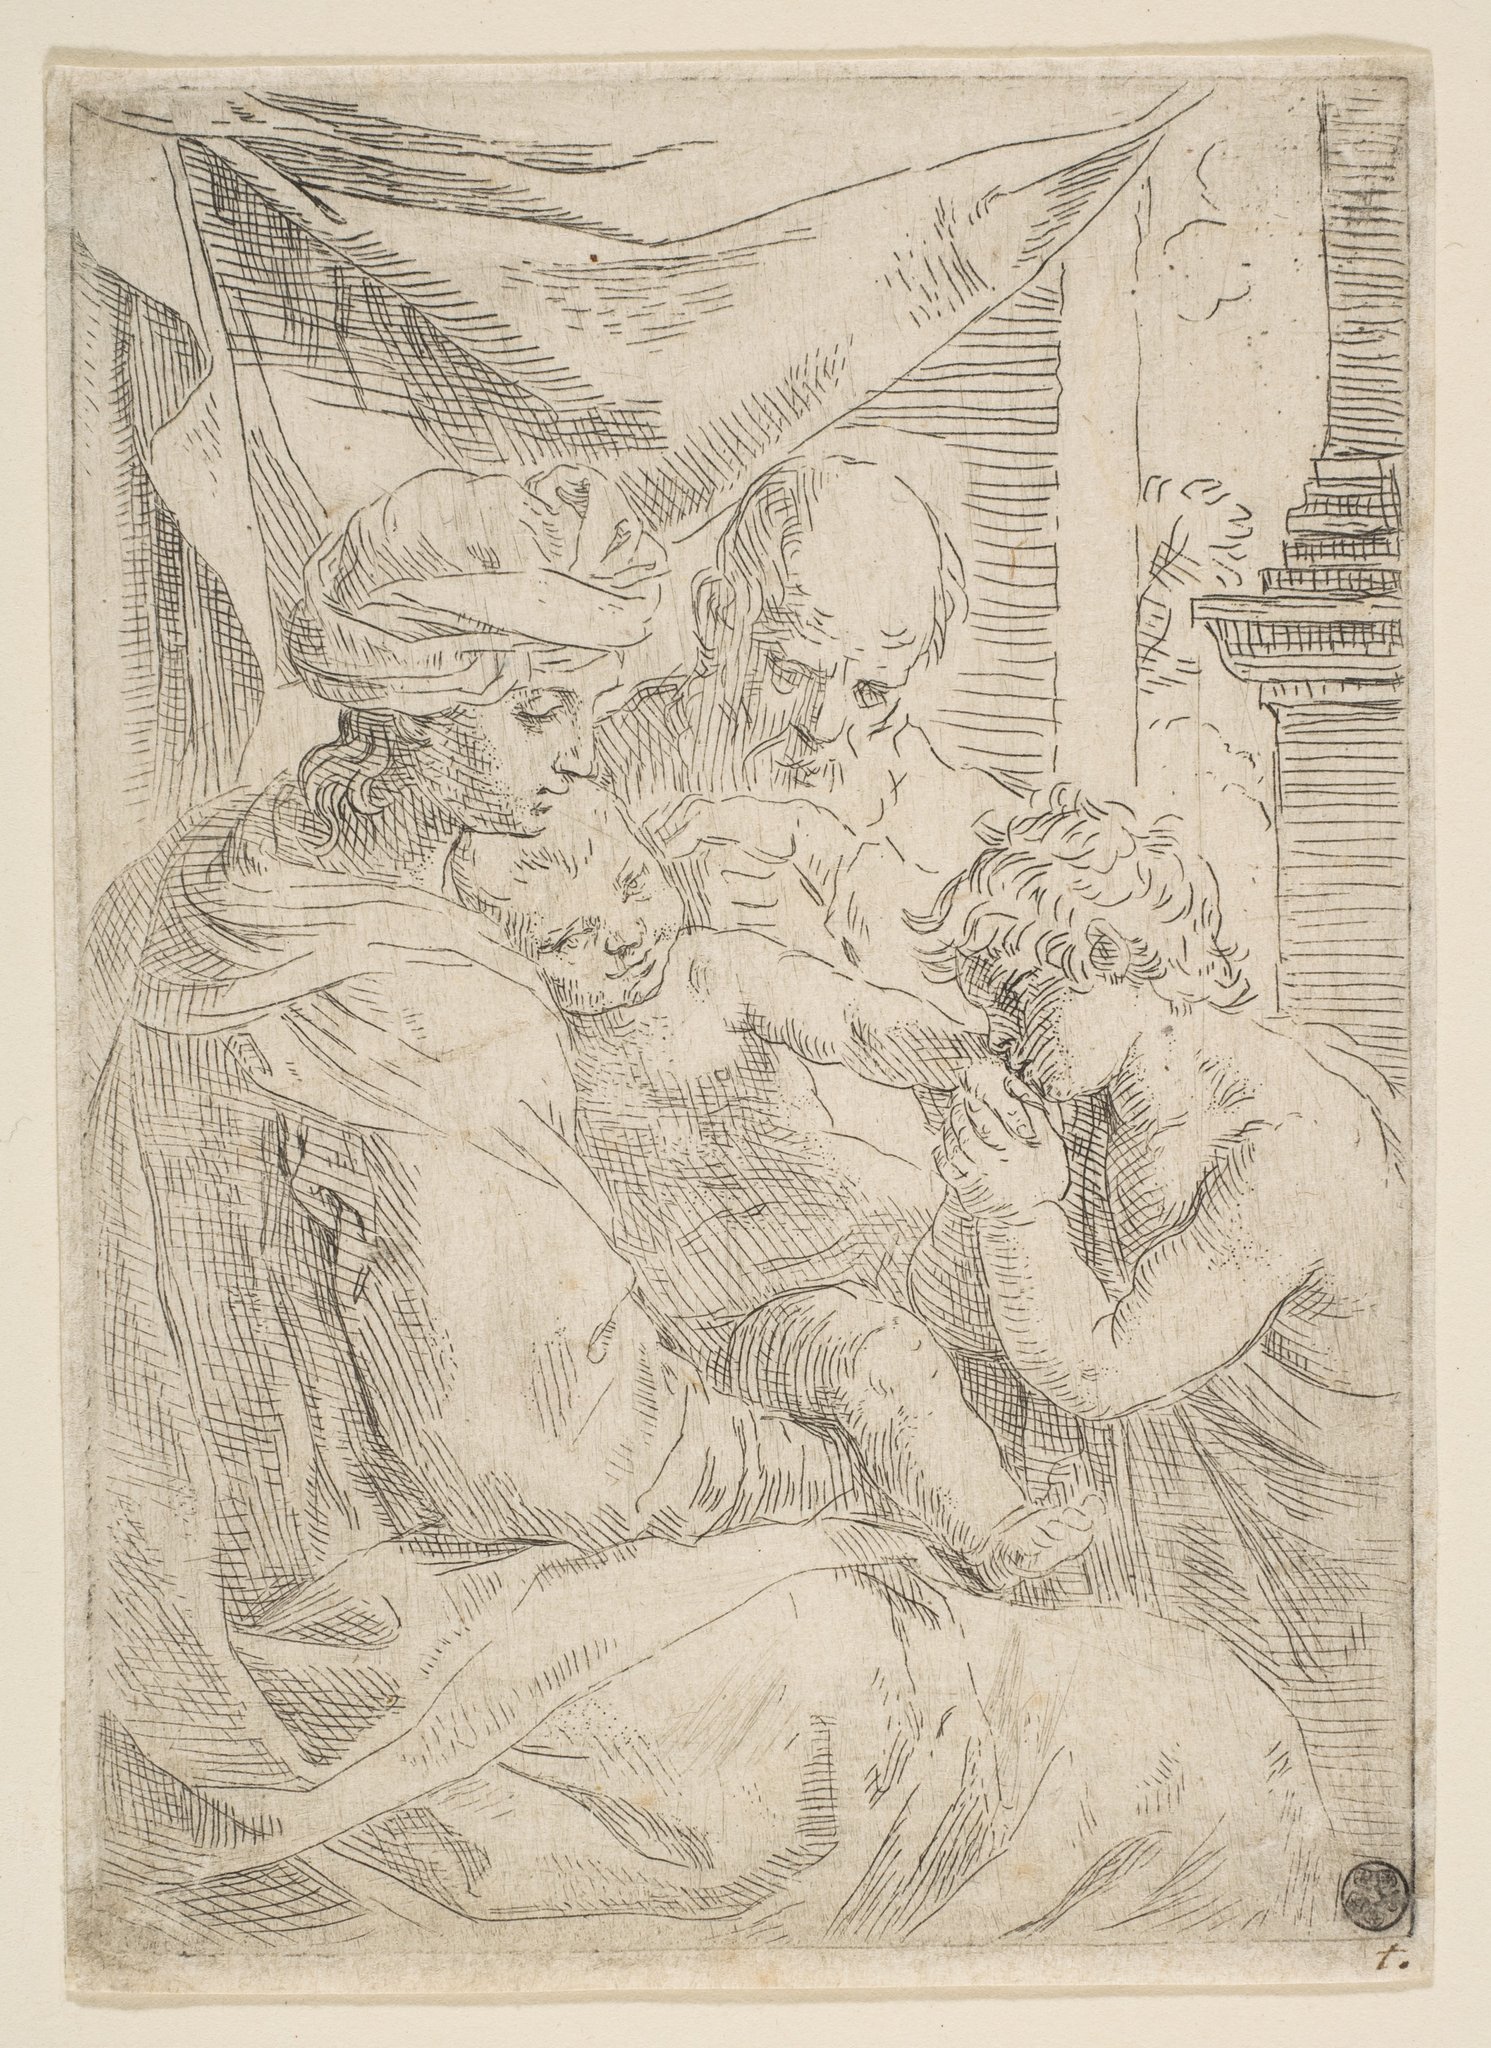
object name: print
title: Holy Family with Saint John the Baptist kissing the infant Christ's hand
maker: simone cantarini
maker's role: artist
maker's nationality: italian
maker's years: 1612-1648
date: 1642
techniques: etching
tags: holy family,saint john the baptist,jesus